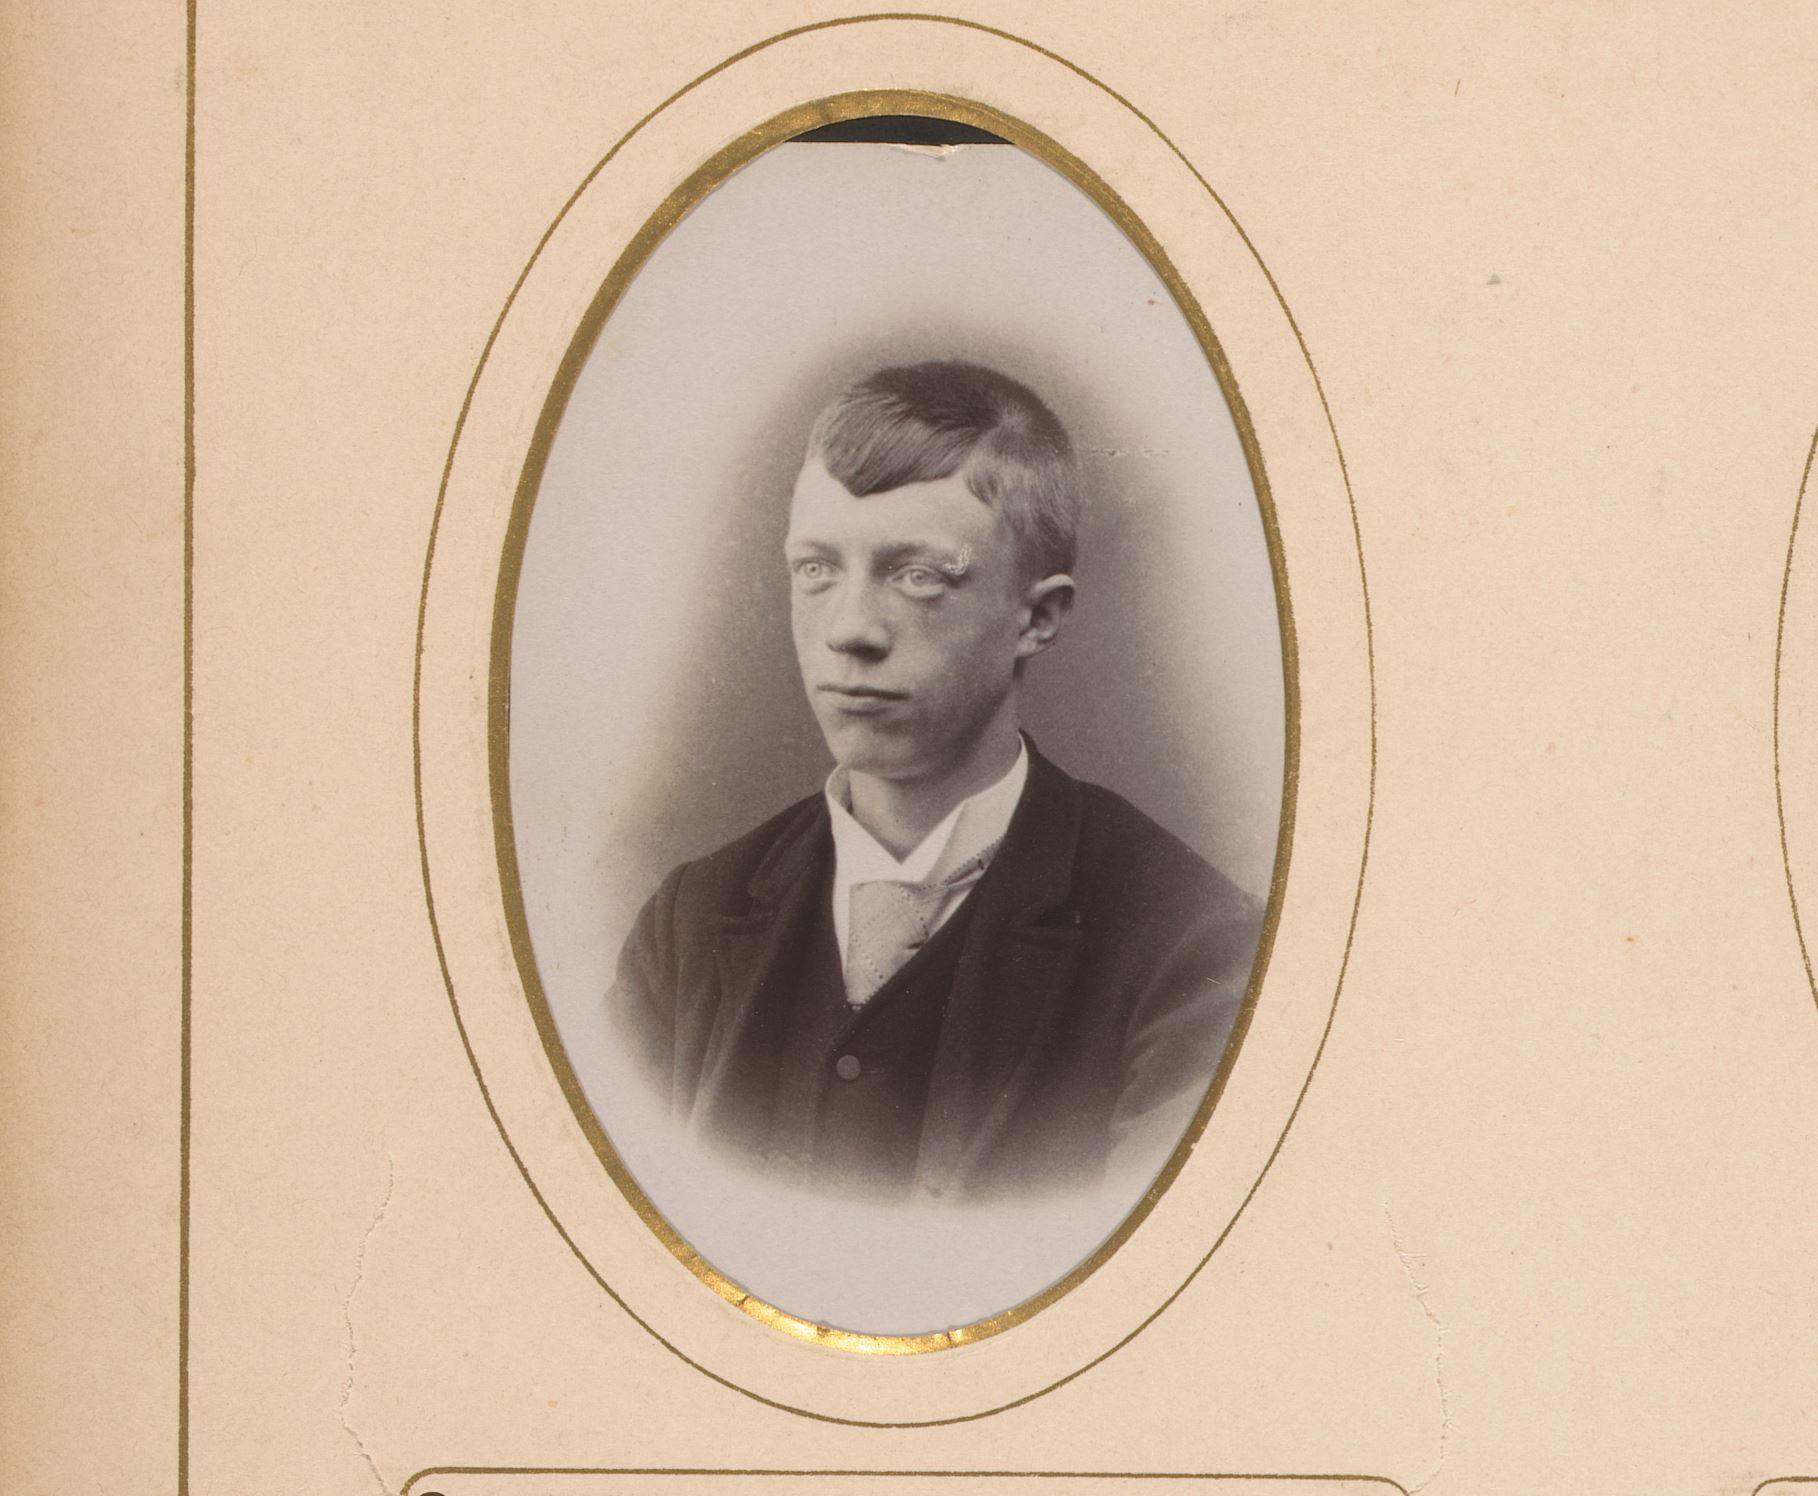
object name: carte de visite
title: Portret van een jonge man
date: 1880-1900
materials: cardboard, photographic support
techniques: collodion silver print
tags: historical persons, youth, adolescent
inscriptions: inscription: ‘Photogr. Atelier/ M. Saaf & Co/ Spoorstraat/ 339,/ Zaandam./ De platen blijven ter nabestelling bewaard./ Inrichting voor Vergrootingen.’